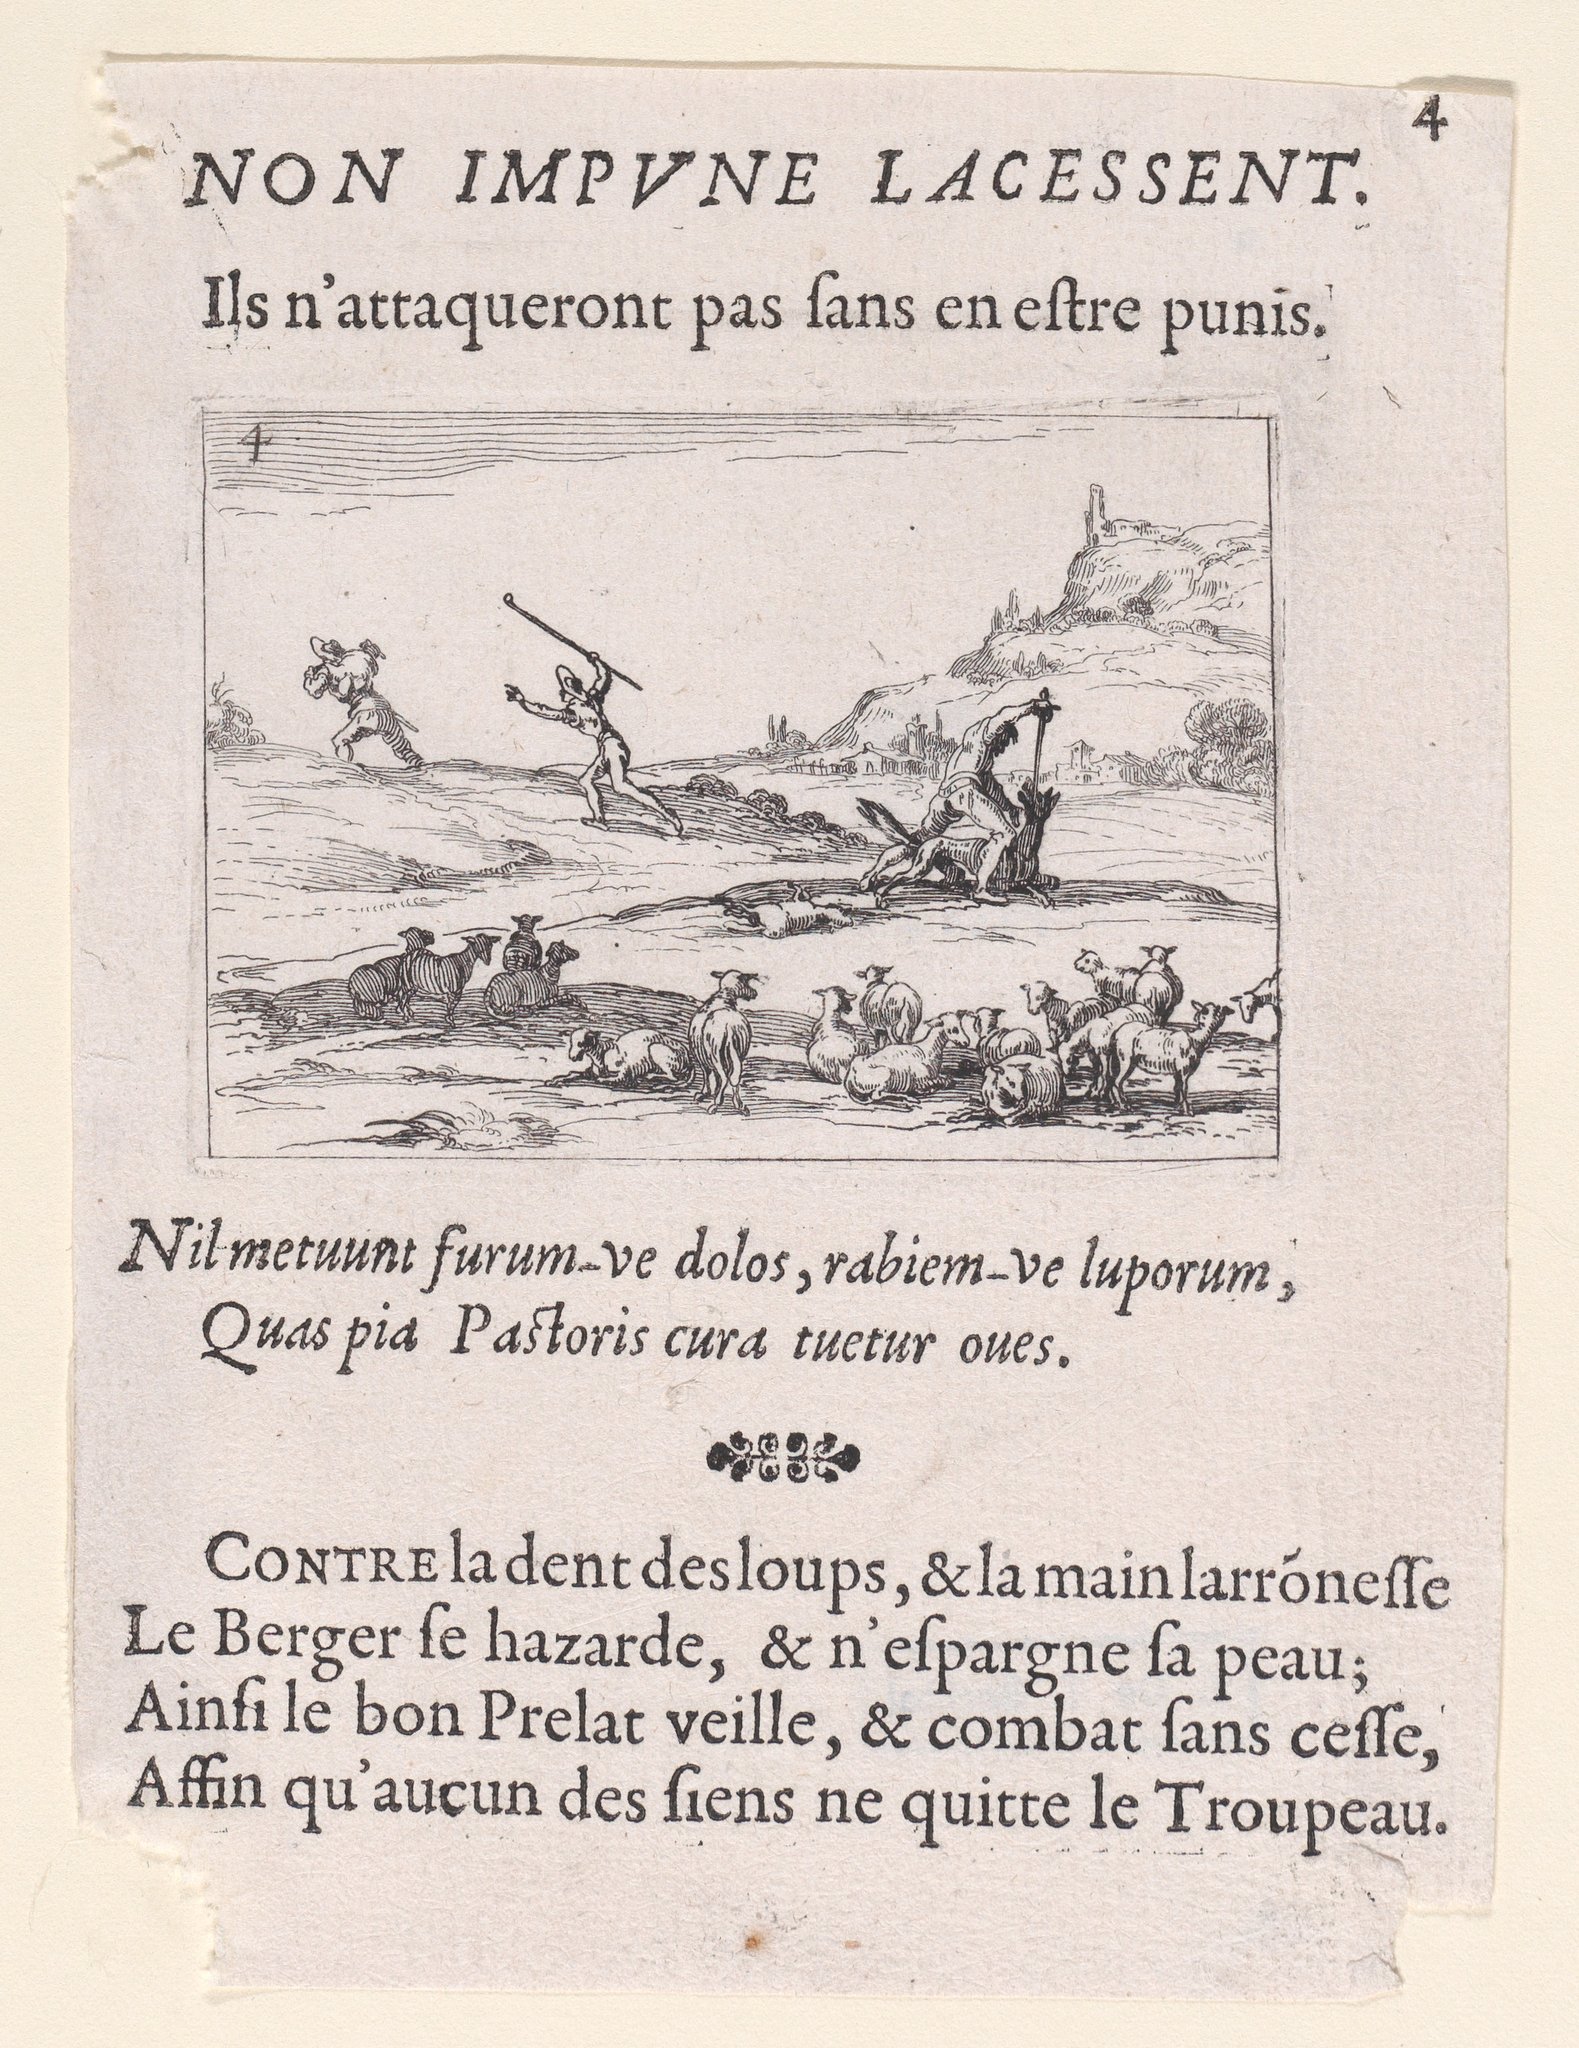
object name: print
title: Les Bergers Défendant leur Troupeau (The Shepherds Defending their Herd), plate 4 from "Lux Claustri ou La Lumière du Cloitre" (The Light of the Cloisters)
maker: jacques callot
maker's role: artist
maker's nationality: french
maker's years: 1592-1635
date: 1625-1631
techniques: etching, letterpress